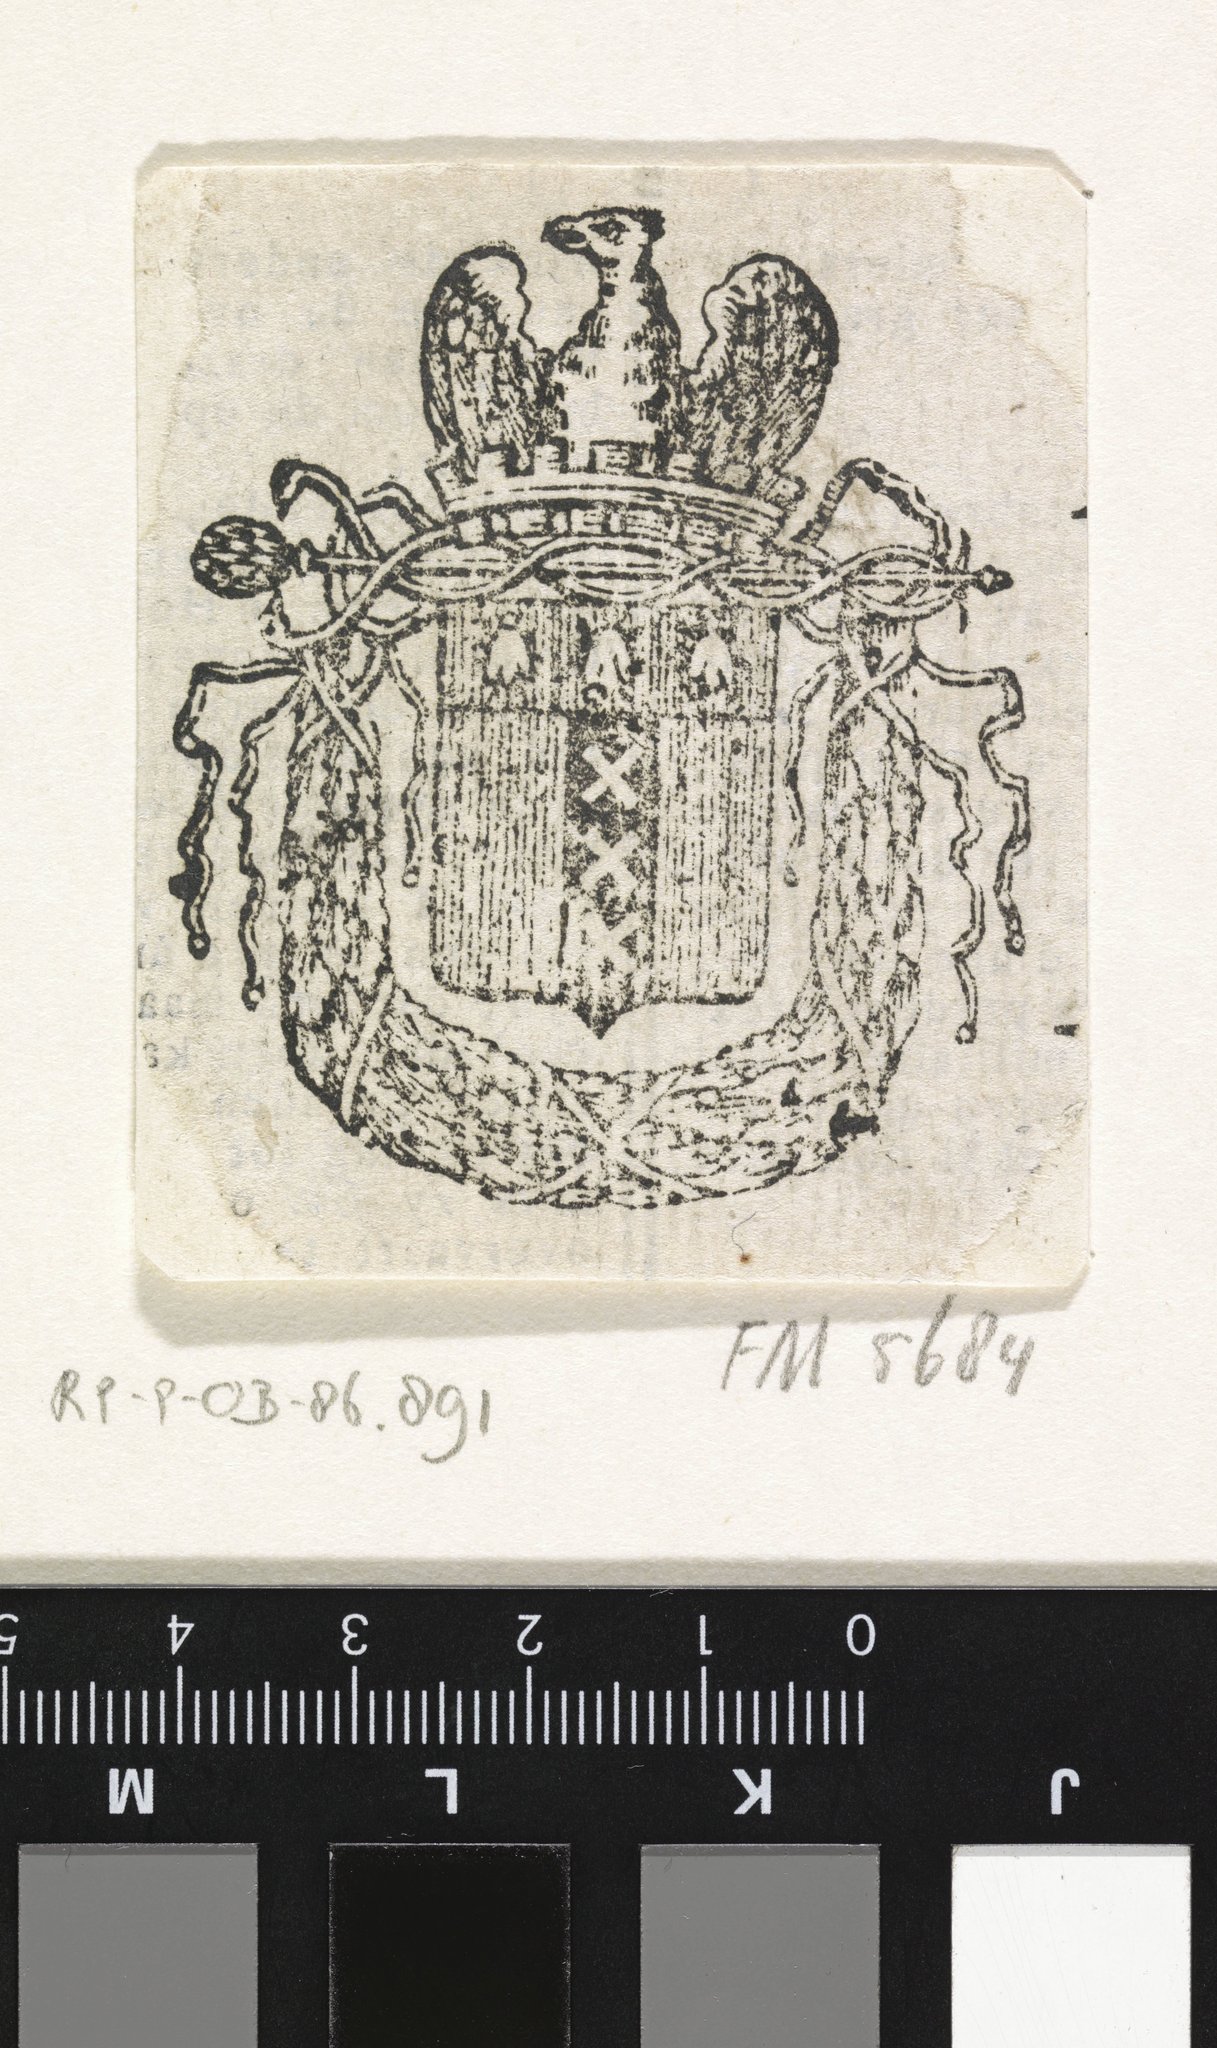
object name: print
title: Zegel, ca. 1806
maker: Anonymous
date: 1806-1810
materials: paper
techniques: woodcut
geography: netherlands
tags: amsterdam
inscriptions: date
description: Afzonderlijke afdruk van een zegel of vignet met het stadswapen van Amsterdam bekroon door de Franse adelaar, ca. 1806.